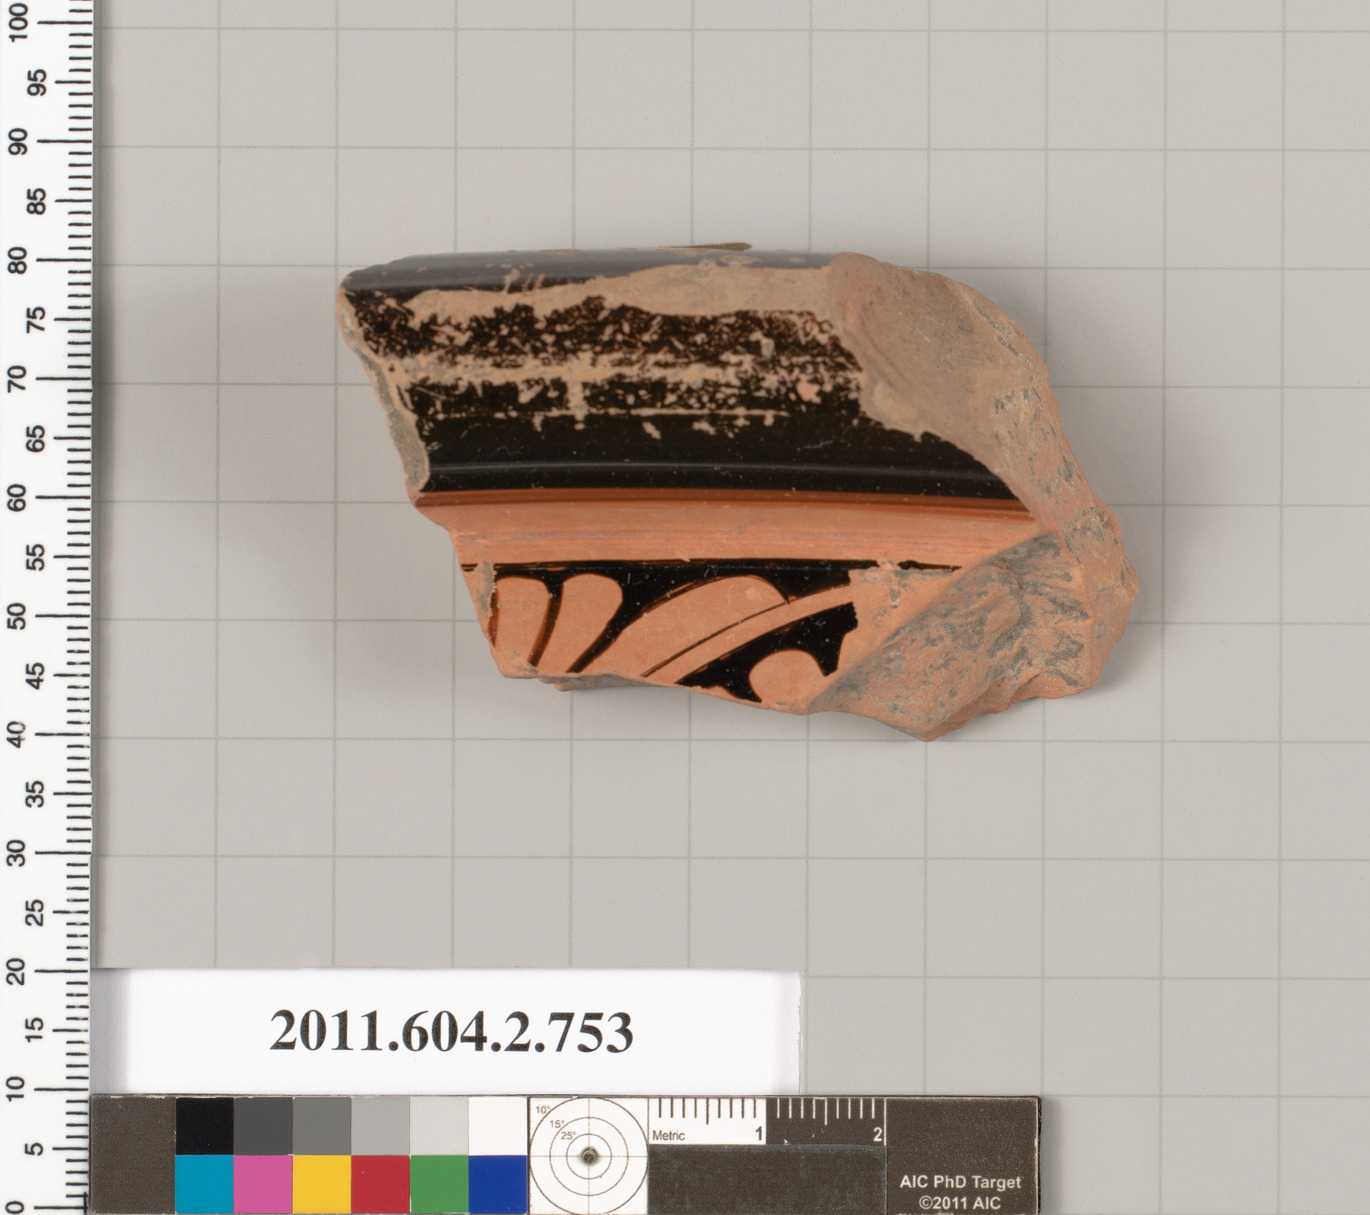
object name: calyx krater fragment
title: Terracotta fragment of a calyx-krater (bowl for mixing wine and water)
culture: greek, attic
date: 475-451 BCE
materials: terracotta